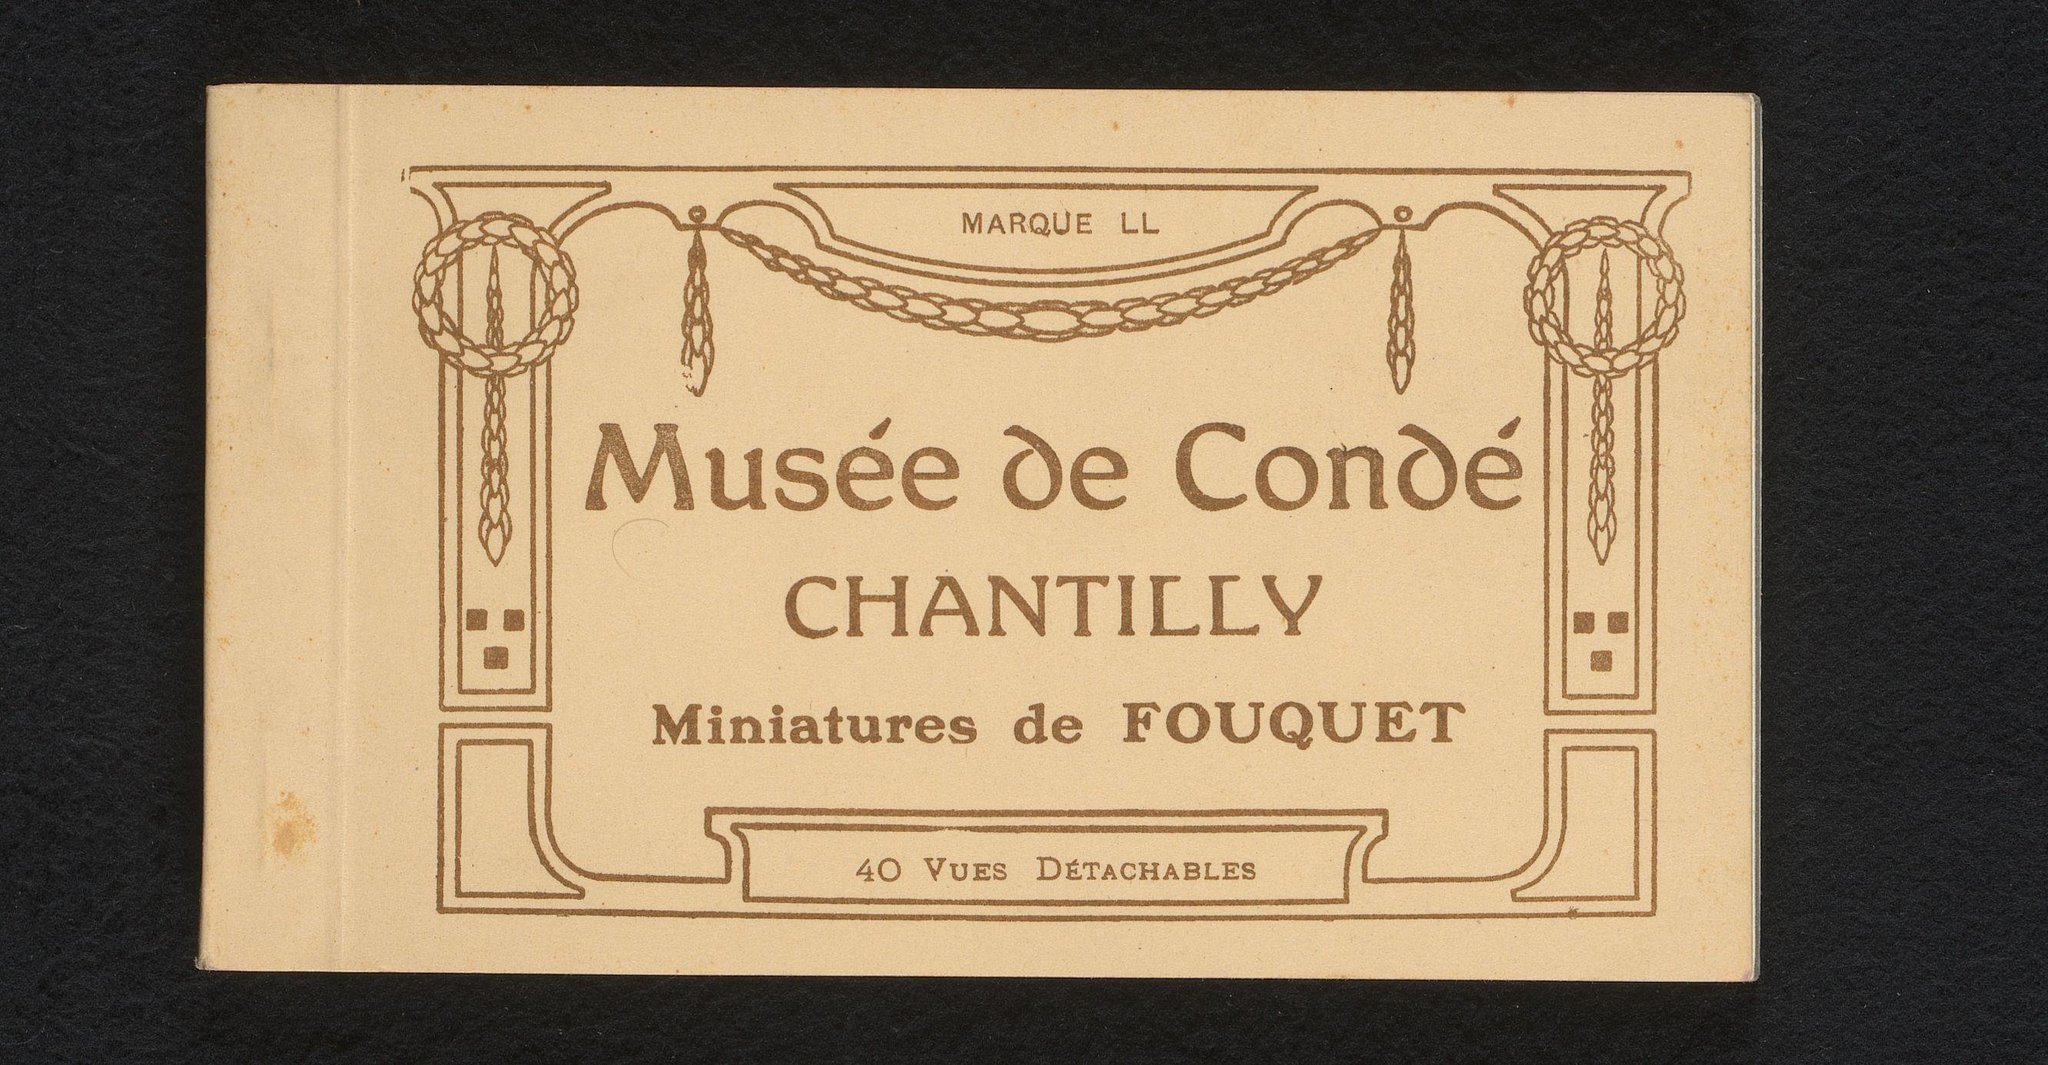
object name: album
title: Album met voorstellingen van schilderijen van Fouquet in het Musée de Condé in Chantilly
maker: Anonymous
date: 1920-1932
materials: cardboard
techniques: photograph, letterpress printing, printing block, stapling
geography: paris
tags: permanent exhibition, museum, picture, painting, chantilly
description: Album met 40 prentbriefkaarten van schilderijen van Fouquet in het Musée de Condé in Chantilly. De prentbriefkaarten kunnen eruit gescheurd worden.